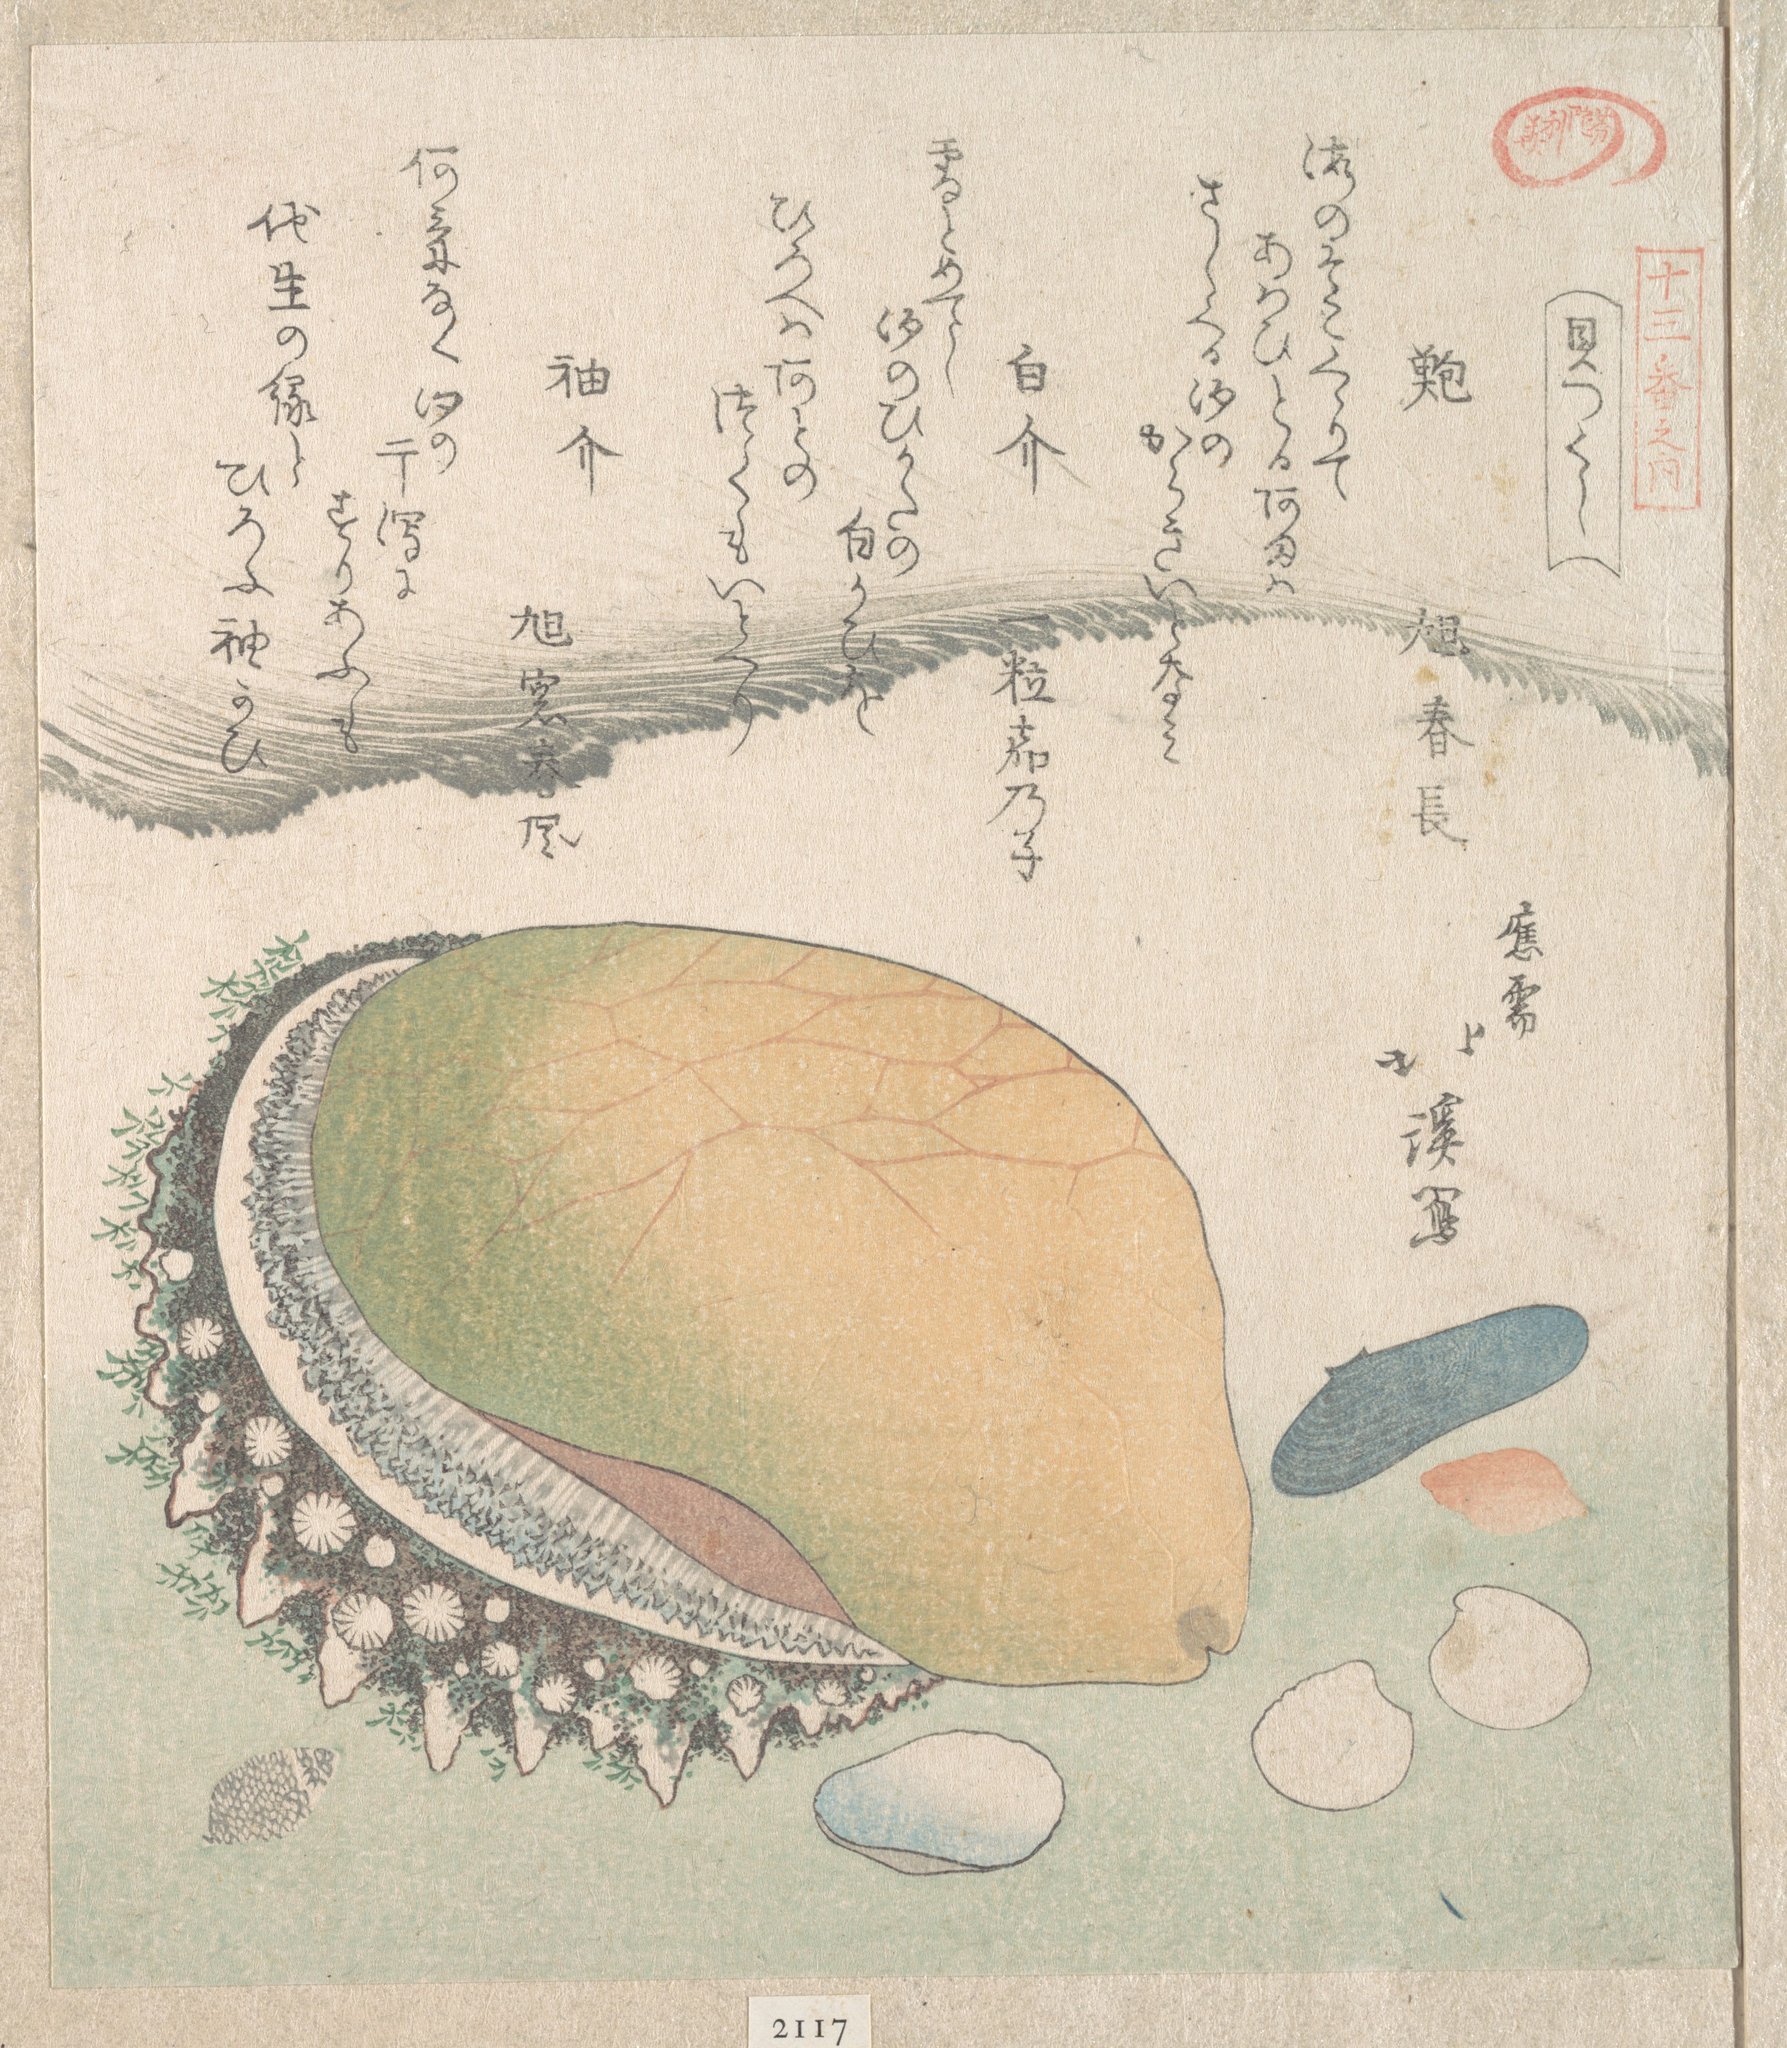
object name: print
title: Awabi (Ear-Shell) and Various Shells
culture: japanese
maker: totoya hokkei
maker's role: artist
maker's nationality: japanese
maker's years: 1780-1850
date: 1801-1900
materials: ink, paper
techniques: surimono, woodblock print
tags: fish,shells